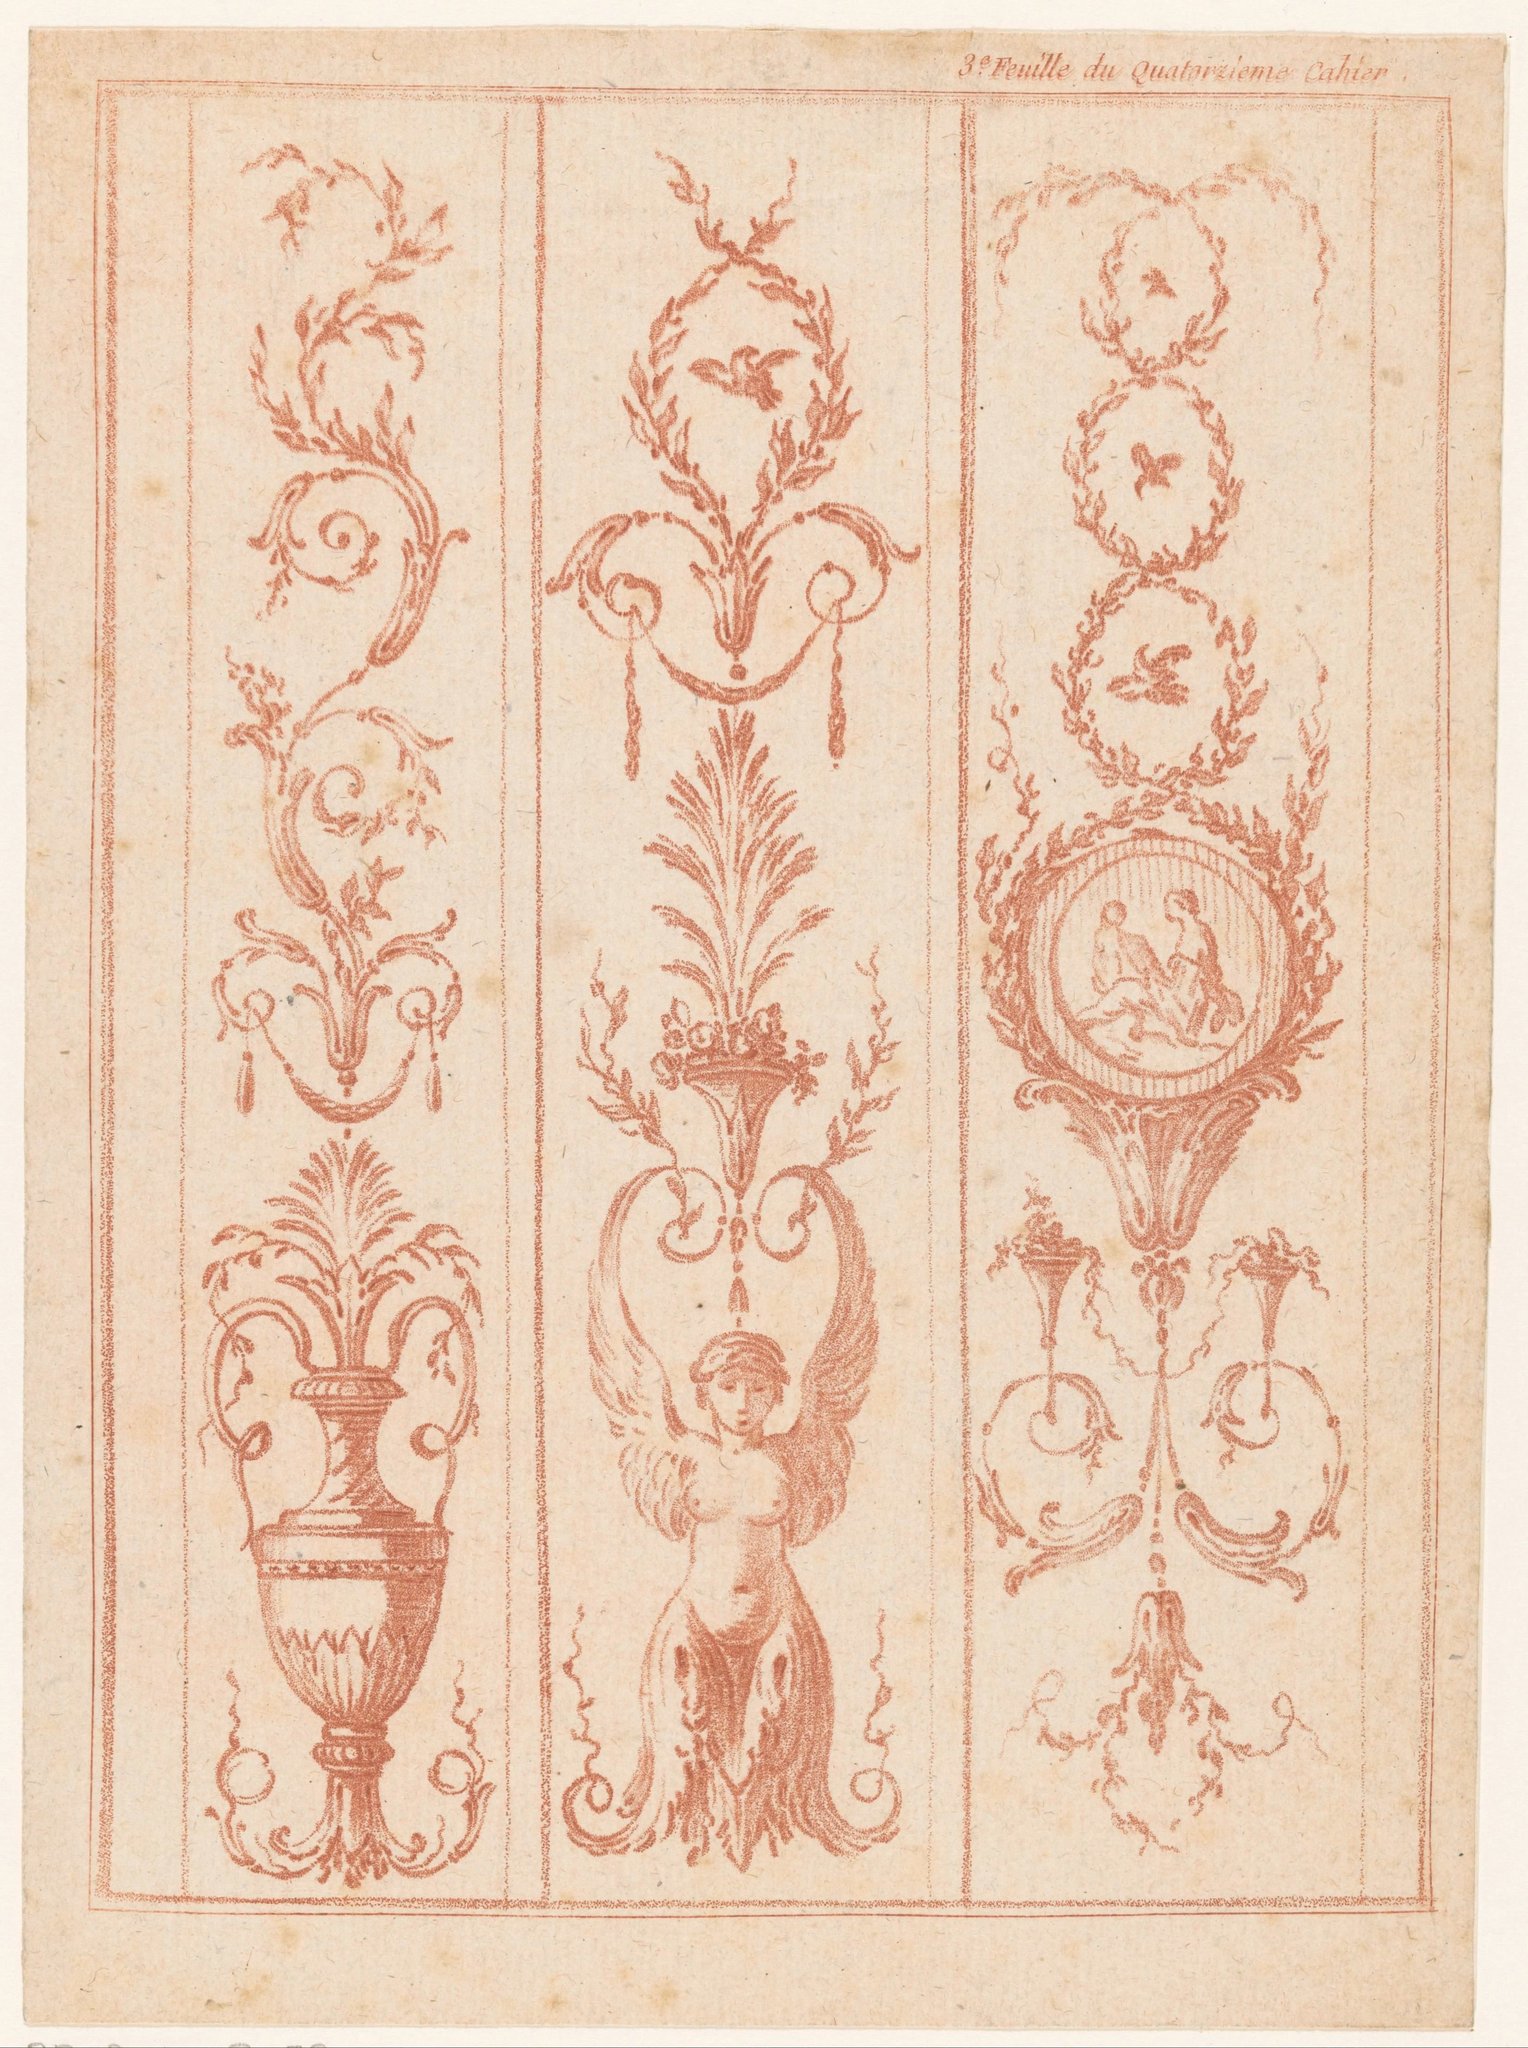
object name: ornament print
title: Drie panelen met arabesken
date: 1770-1780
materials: paper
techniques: printmaking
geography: paris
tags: ornament ~ arabesque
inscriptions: collector's mark: Lugt 2228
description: Drie panelen met arabesken, een vaas, een gevleugelde vrouw en een rond medaillon met twee figuren.